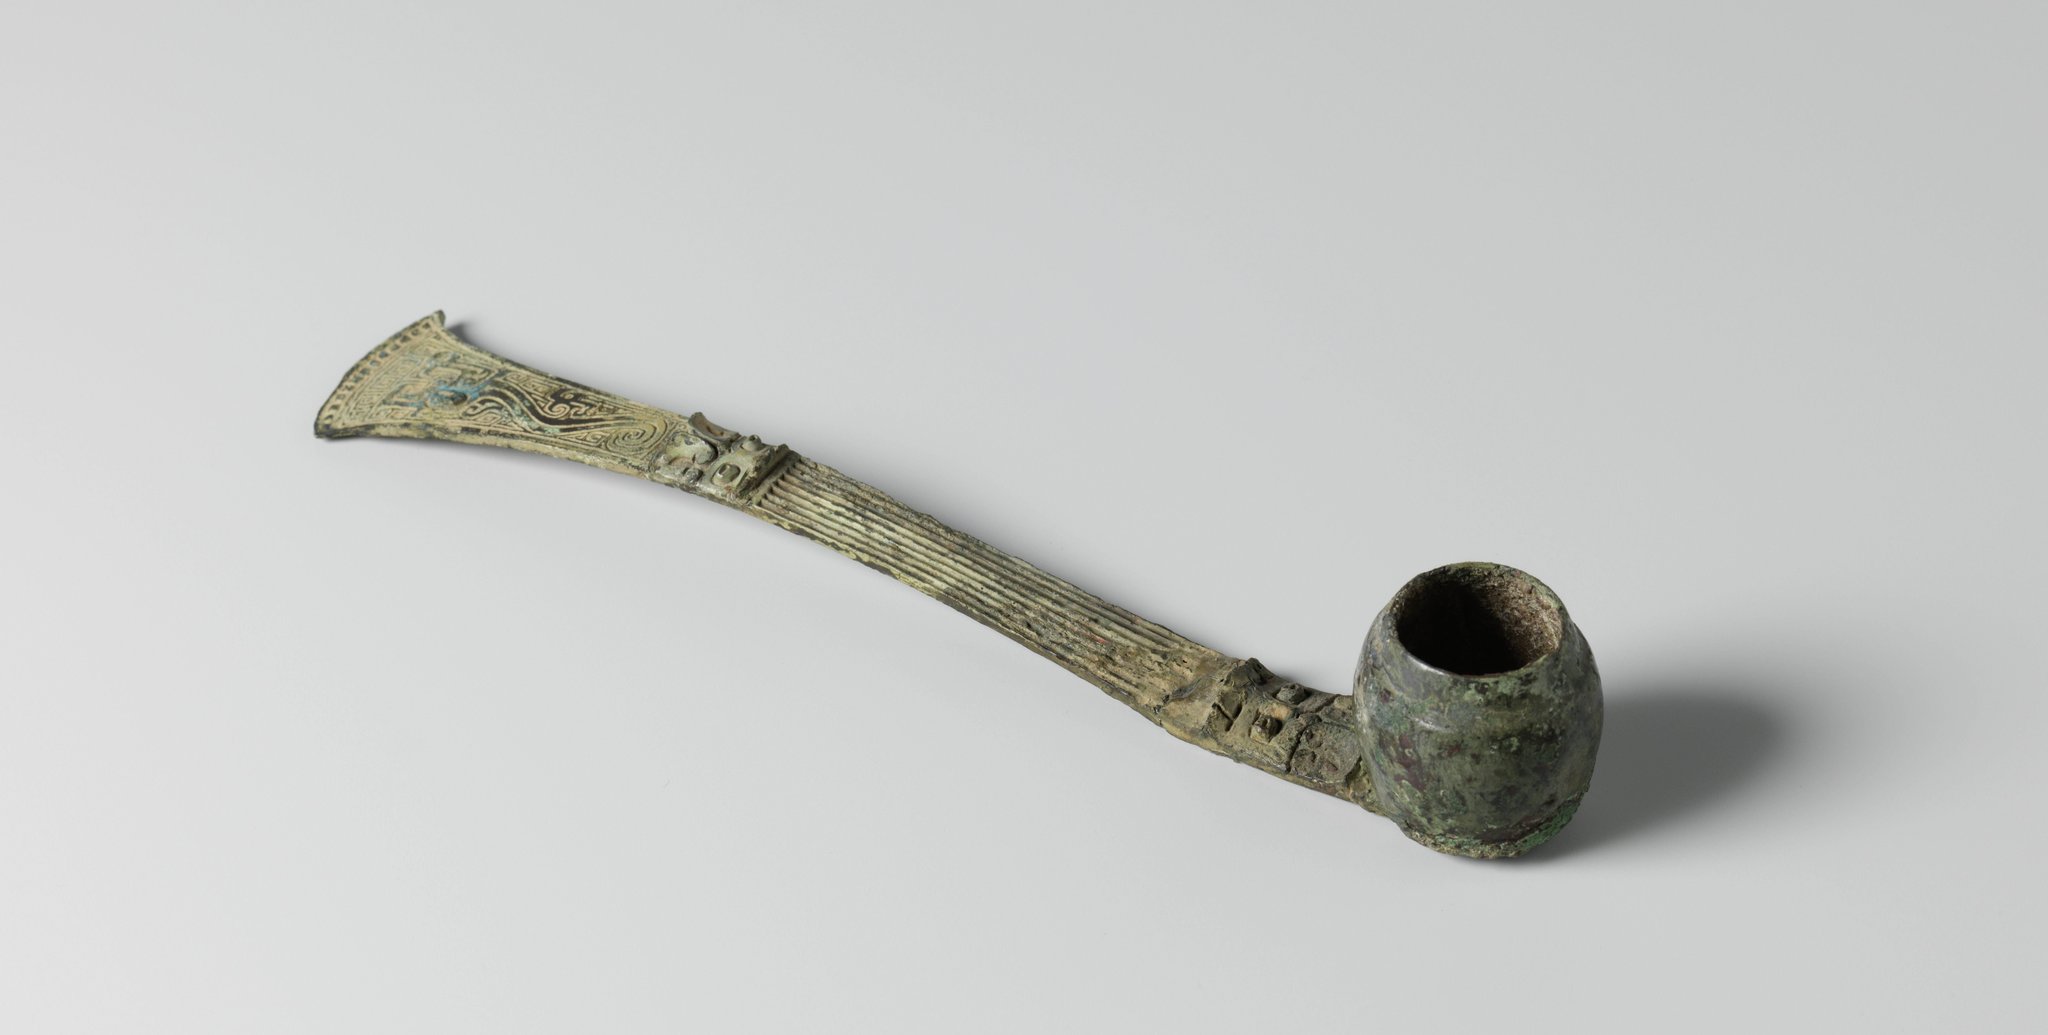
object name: religious ritual object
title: Ritual wine scoop with monster heads and a dragon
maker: Anonymous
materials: bronze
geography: china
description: Rituele wijnlepel met een pijpekop-vormig reservoir dat door twee monsterkoppen en een geprofileerde steel verbonden is met het handvat.